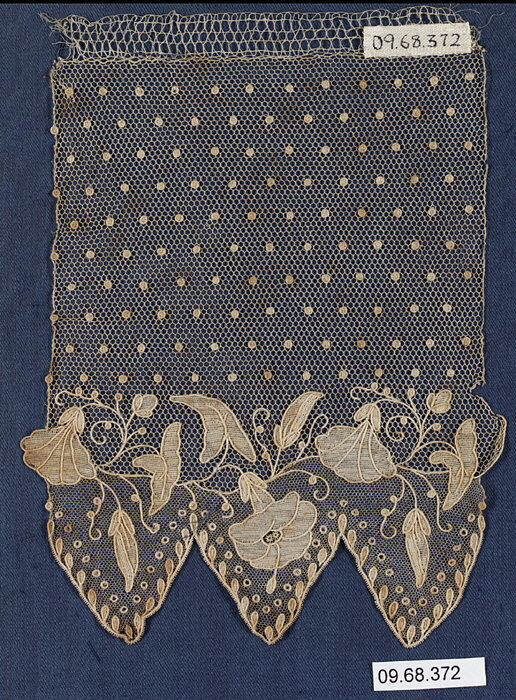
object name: fragment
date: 1801-1900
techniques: lace